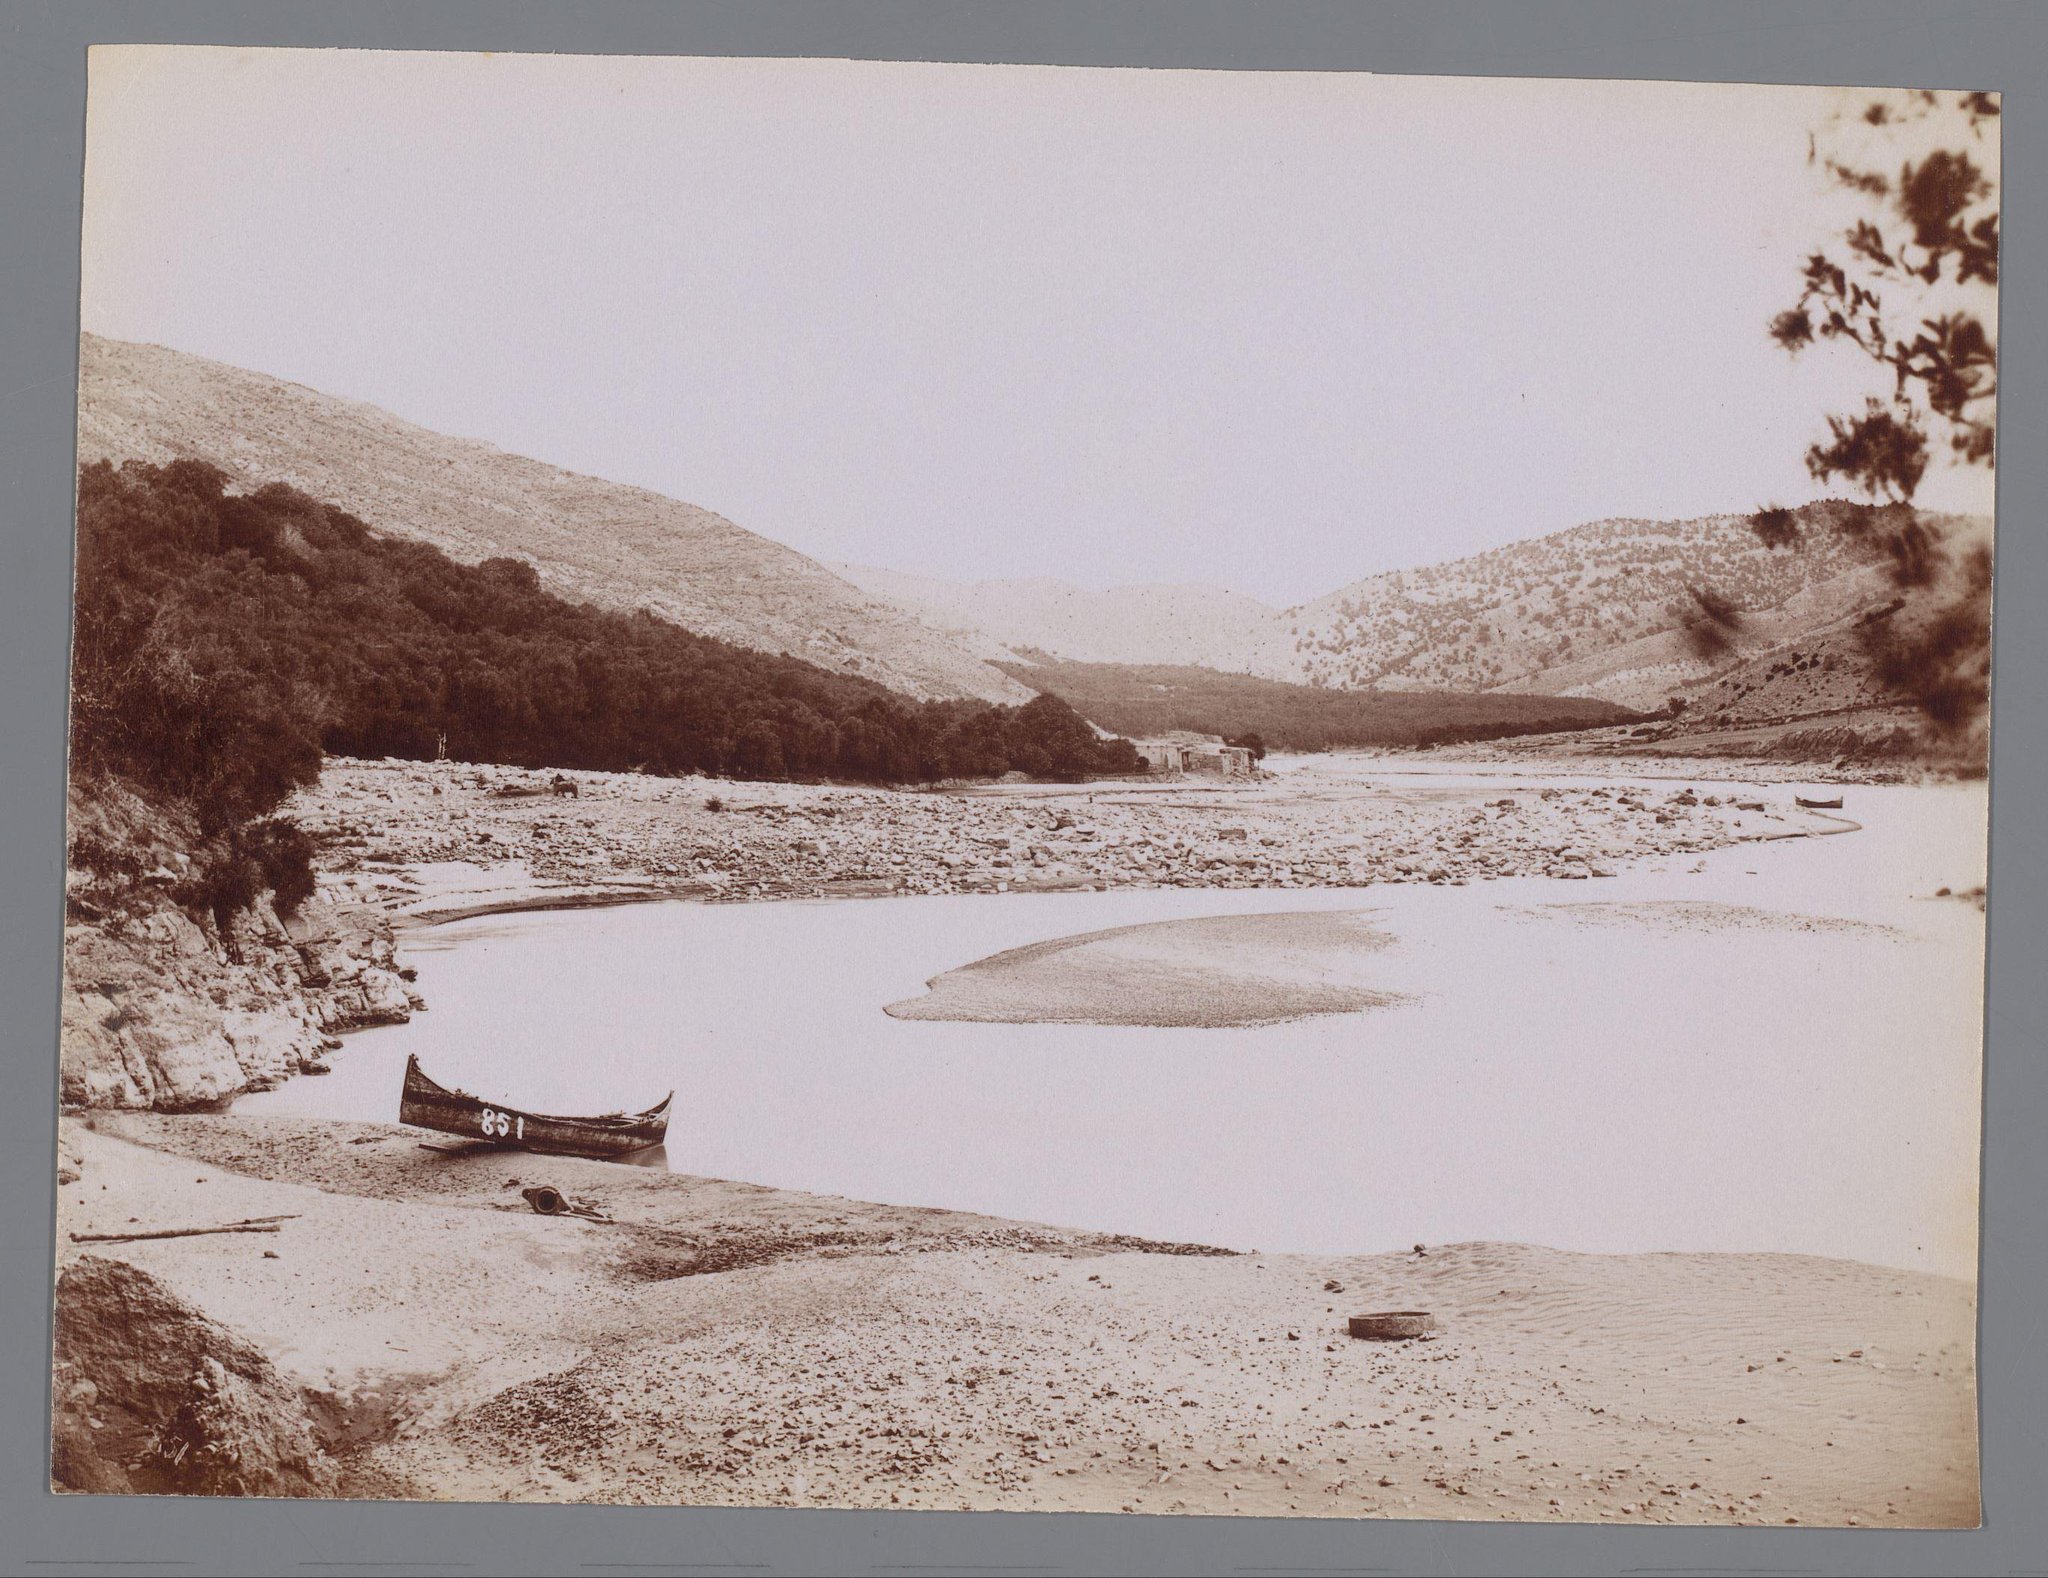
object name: photograph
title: Landschap met meer en bootje ("La route de Rescht"), Iran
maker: antoine sevruguin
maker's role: fotograaf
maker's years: 1840-1933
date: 1880-1910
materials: paper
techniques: albumen print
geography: iran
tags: iran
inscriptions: inscription: ‘La route de Rescht//Remllear [?]’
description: Landschap met meer en bootje ("La route de Rescht"), Iran.